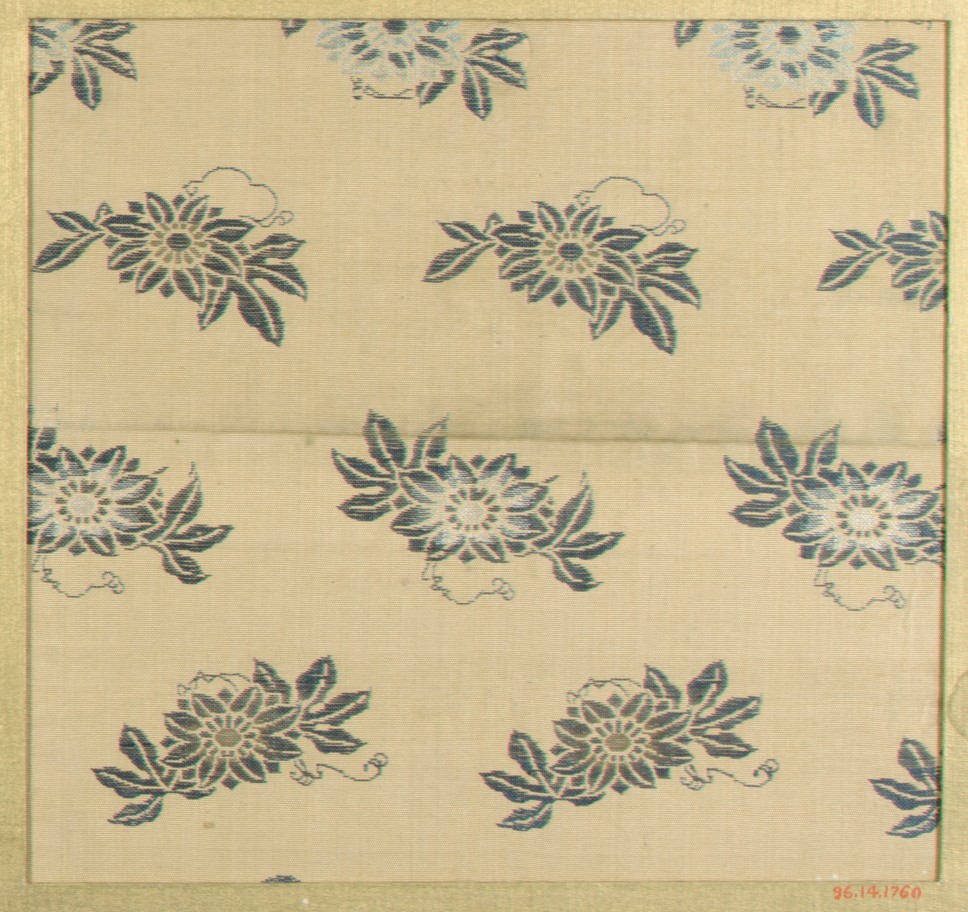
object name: piece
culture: japanese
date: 1701-1900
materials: silk